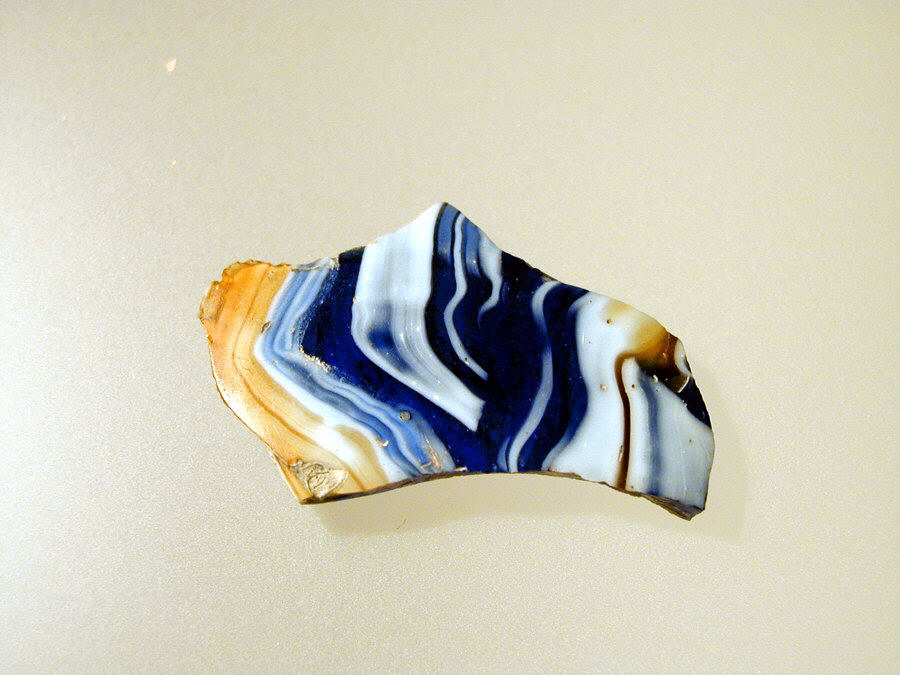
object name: fragment, mosaic bowl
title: Glass mosaic bowl fragment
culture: roman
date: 34 BCE-33 CE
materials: glass